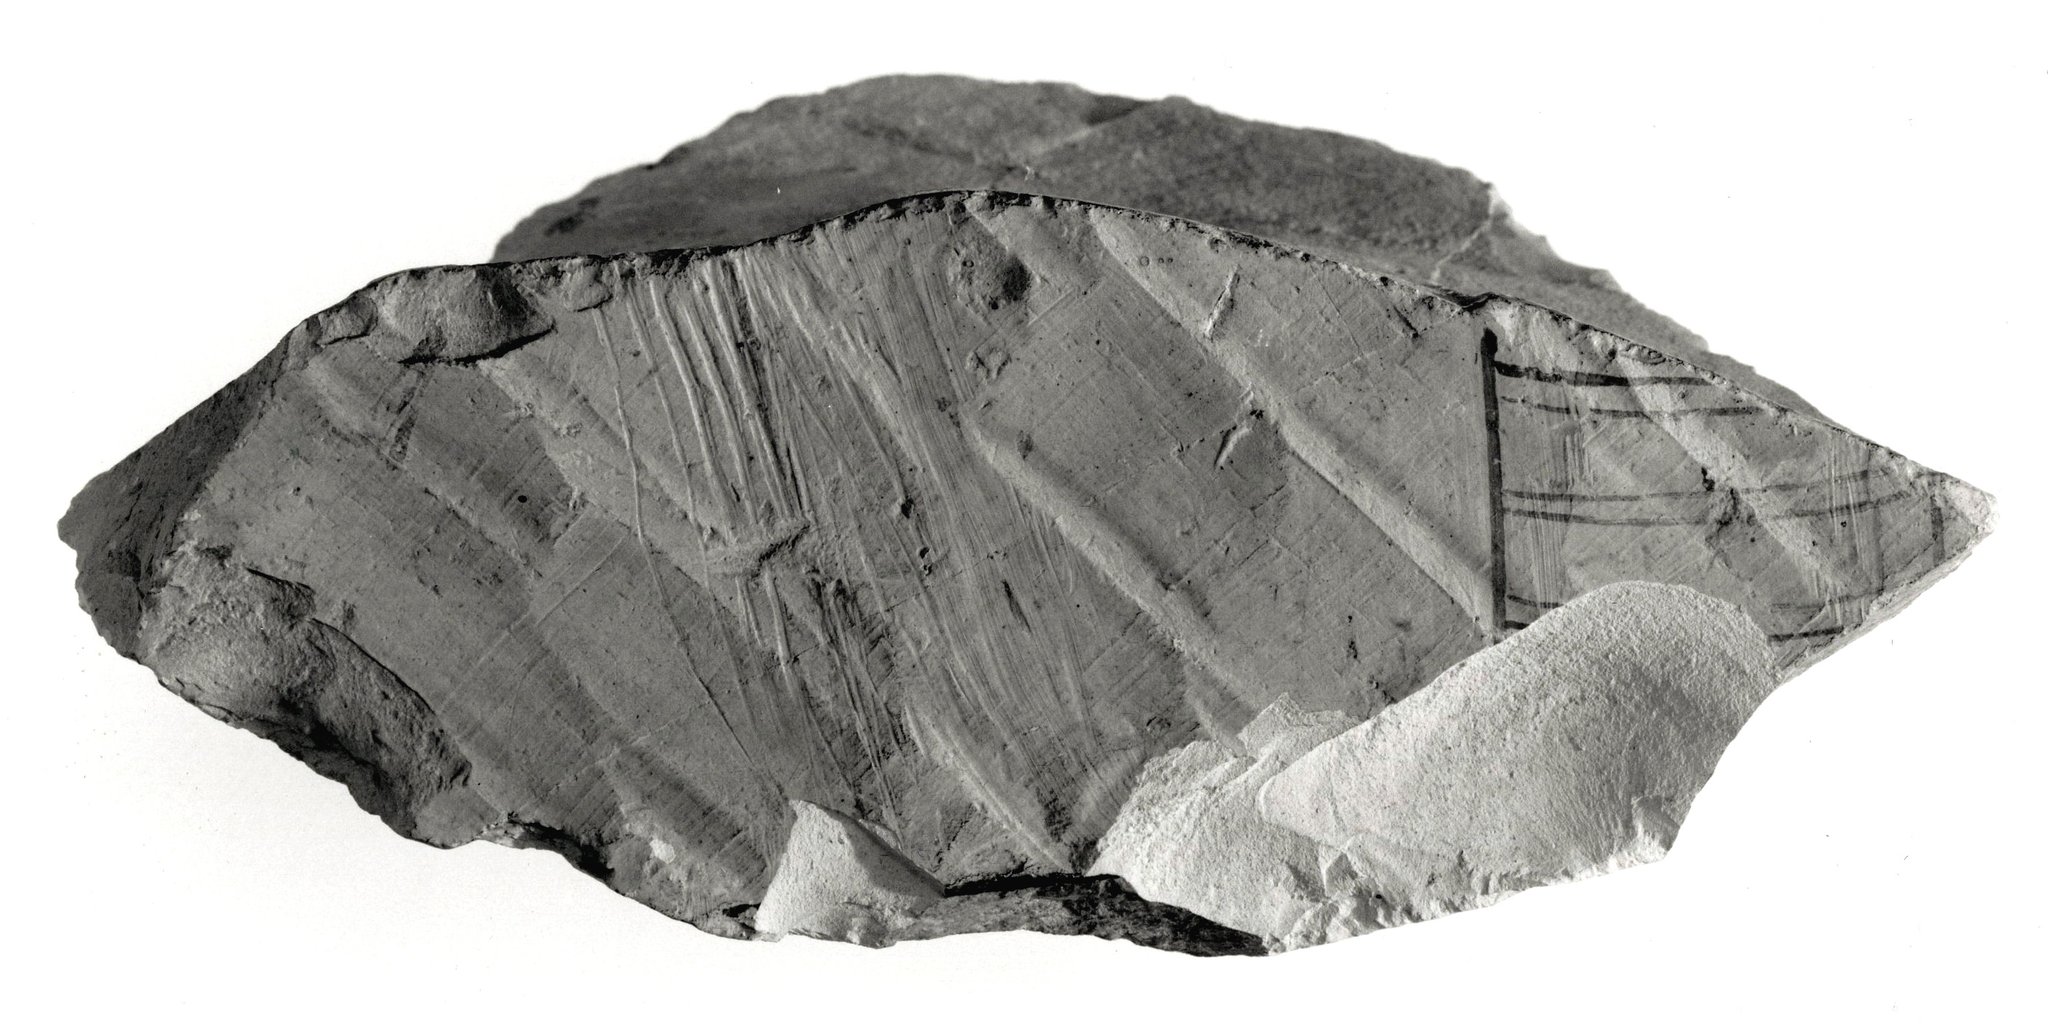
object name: relief, tomb of nespekashuty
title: Fragment depicting a part of a drawing of funerary boat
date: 664-610 BCE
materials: limestone, varnish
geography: egypt